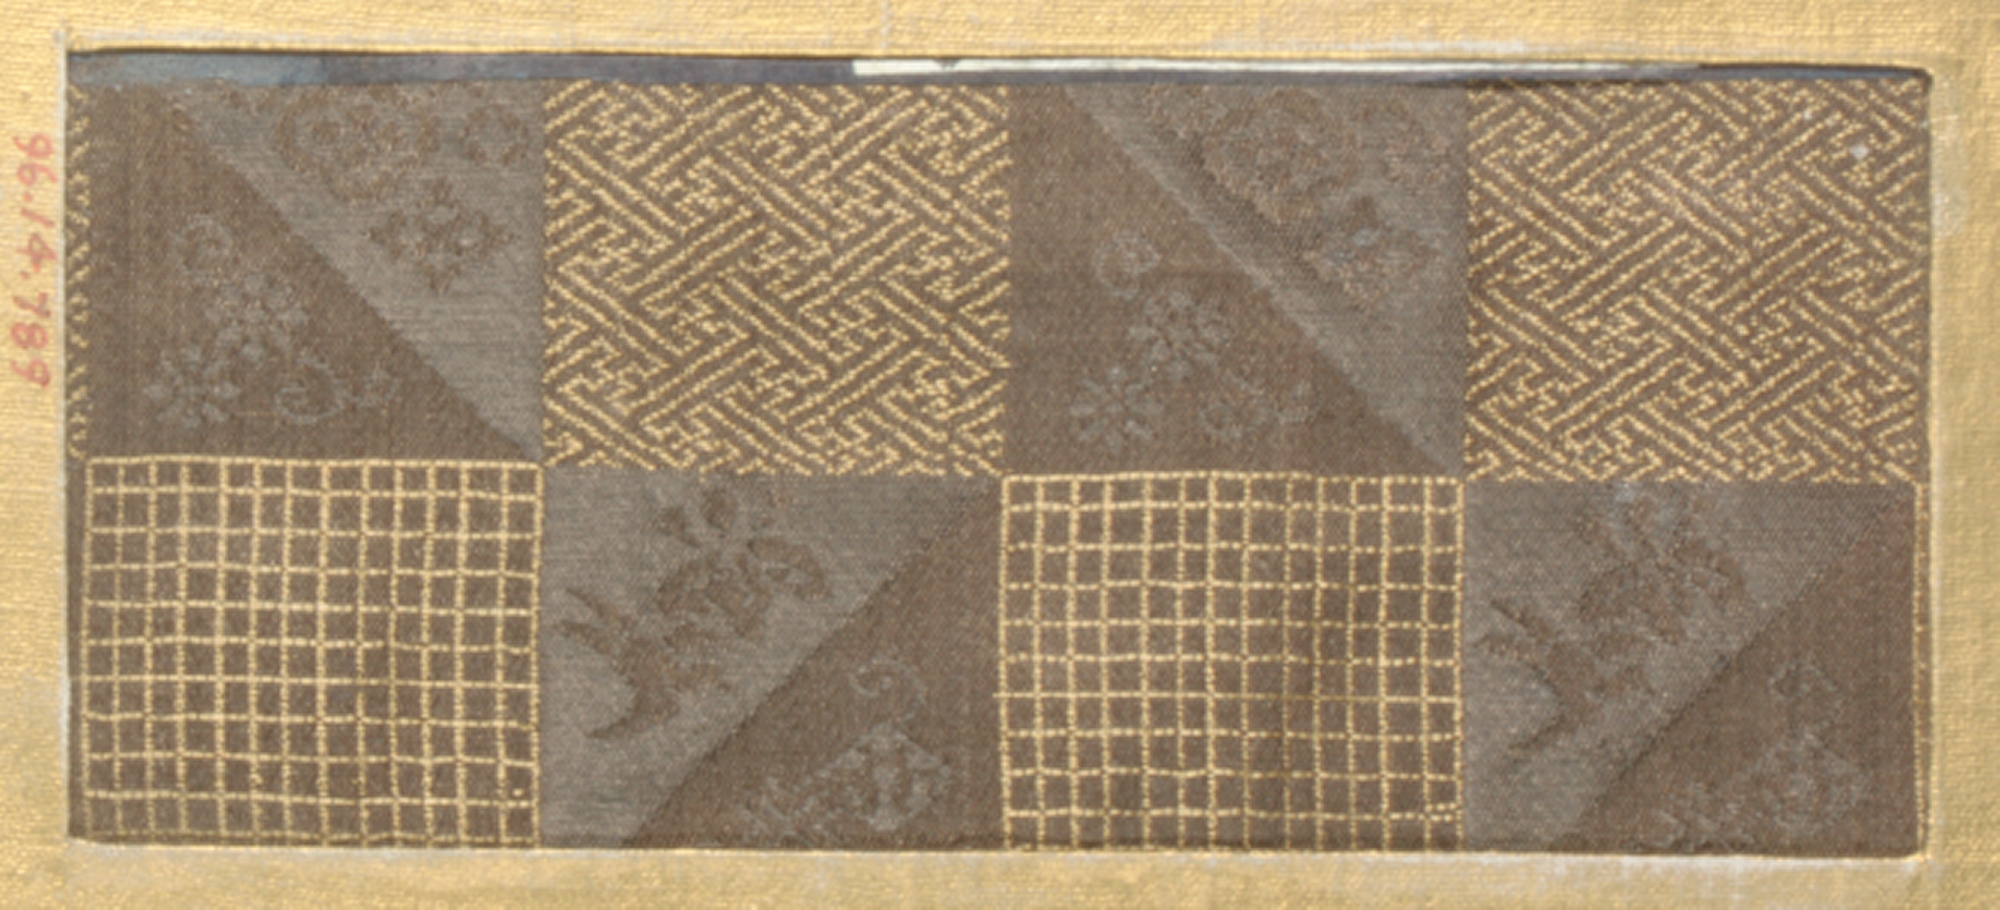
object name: piece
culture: japanese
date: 1701-1900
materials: silk